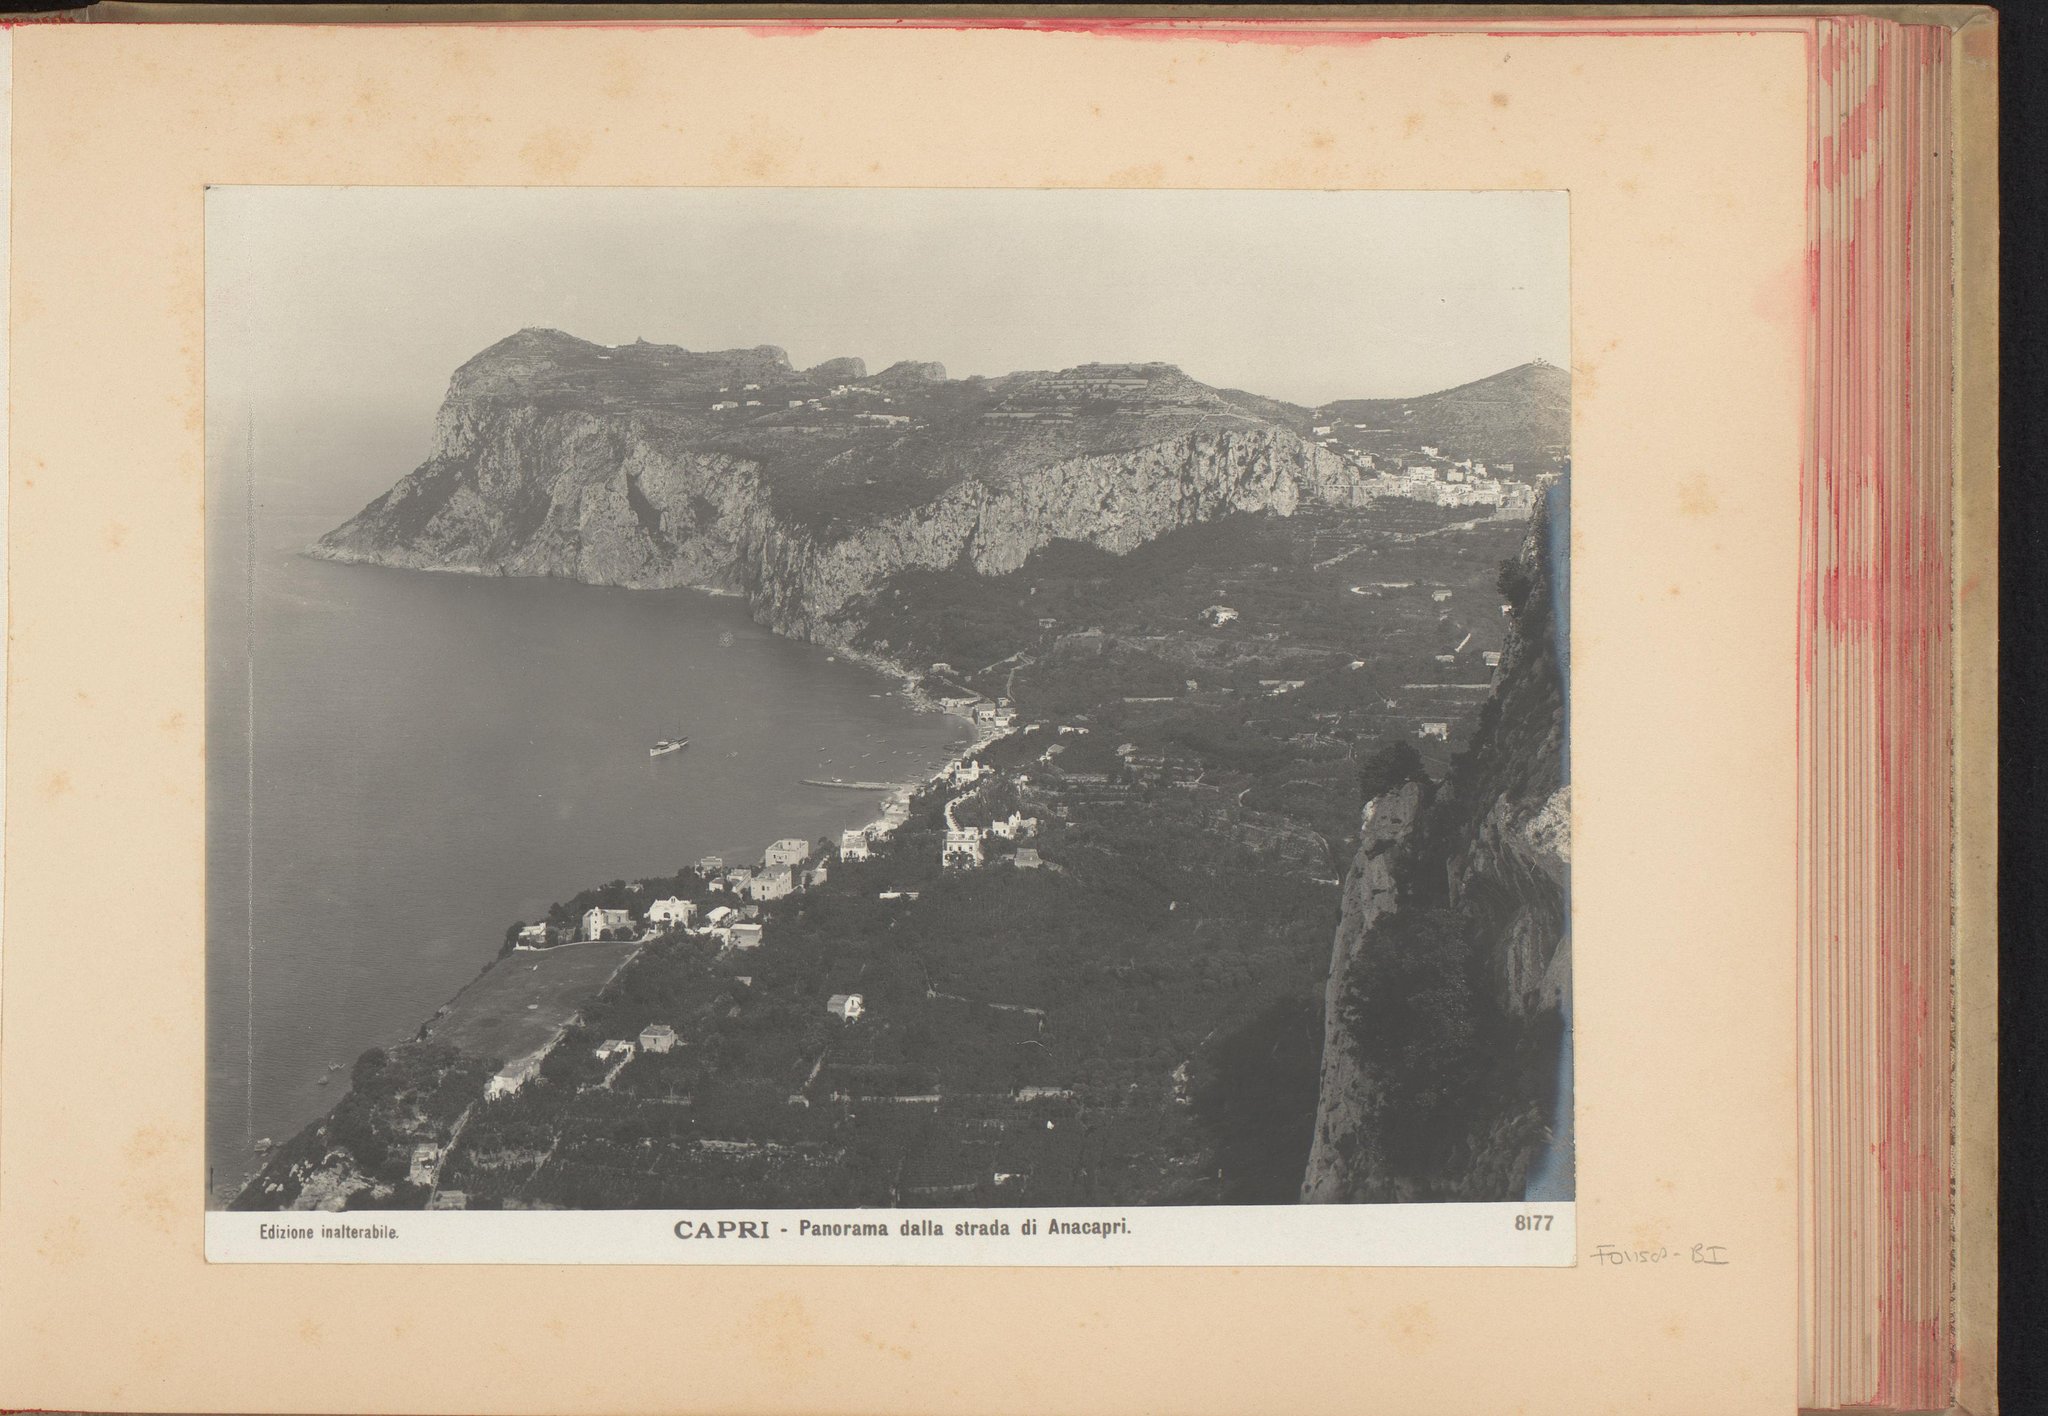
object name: photograph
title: Capri - Panorama dalla strada di Anacapri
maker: Anonymous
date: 1875-1907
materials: photographic support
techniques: gelatin silver print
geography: anacapri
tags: city-view in general; 'veduta', coastal cliff or crag, capri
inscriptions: number: ‘8177’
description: Onderdeel van Fotoalbum met opnames van bezienswaardigheden en kunstwerken in Italië.